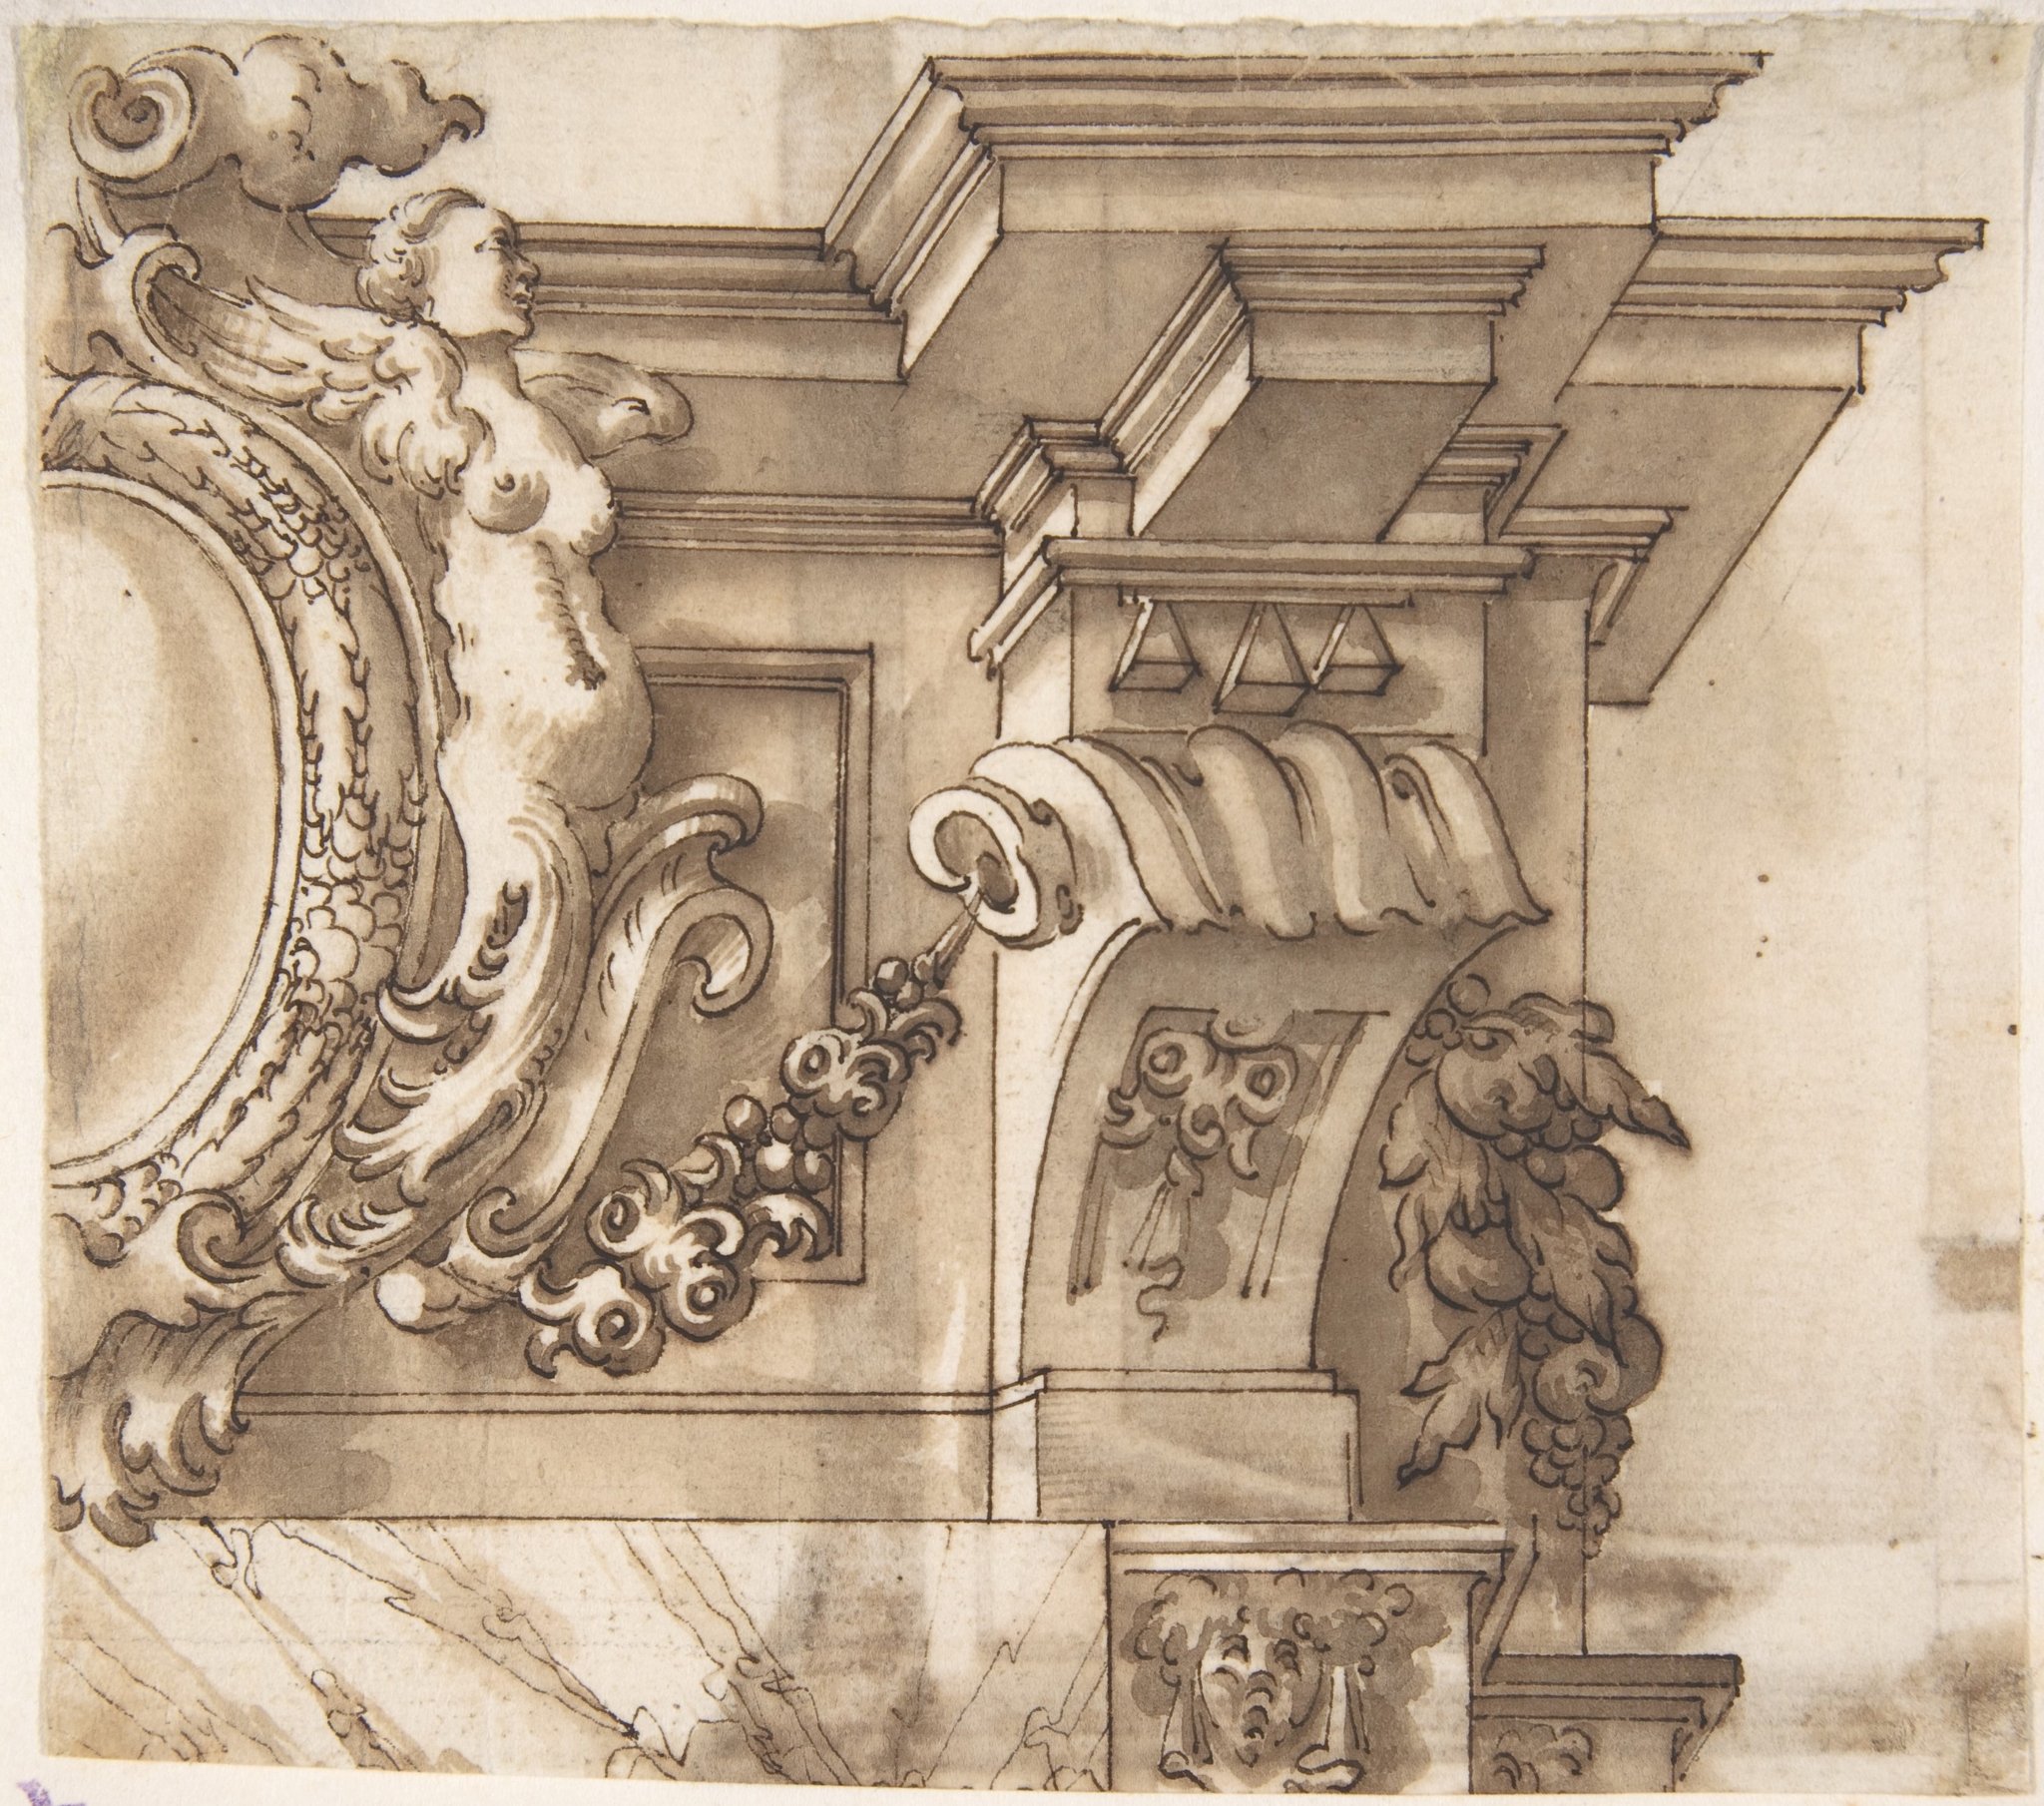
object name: drawing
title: Design for an Overdoor Decoration (?) (recto); Part of a Doorway (verso)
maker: anonymous, italian, bolognese, 18th century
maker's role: artist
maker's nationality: italian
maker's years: 1700-1800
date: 1740-1760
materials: chalk, ink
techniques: brush, pen, wash